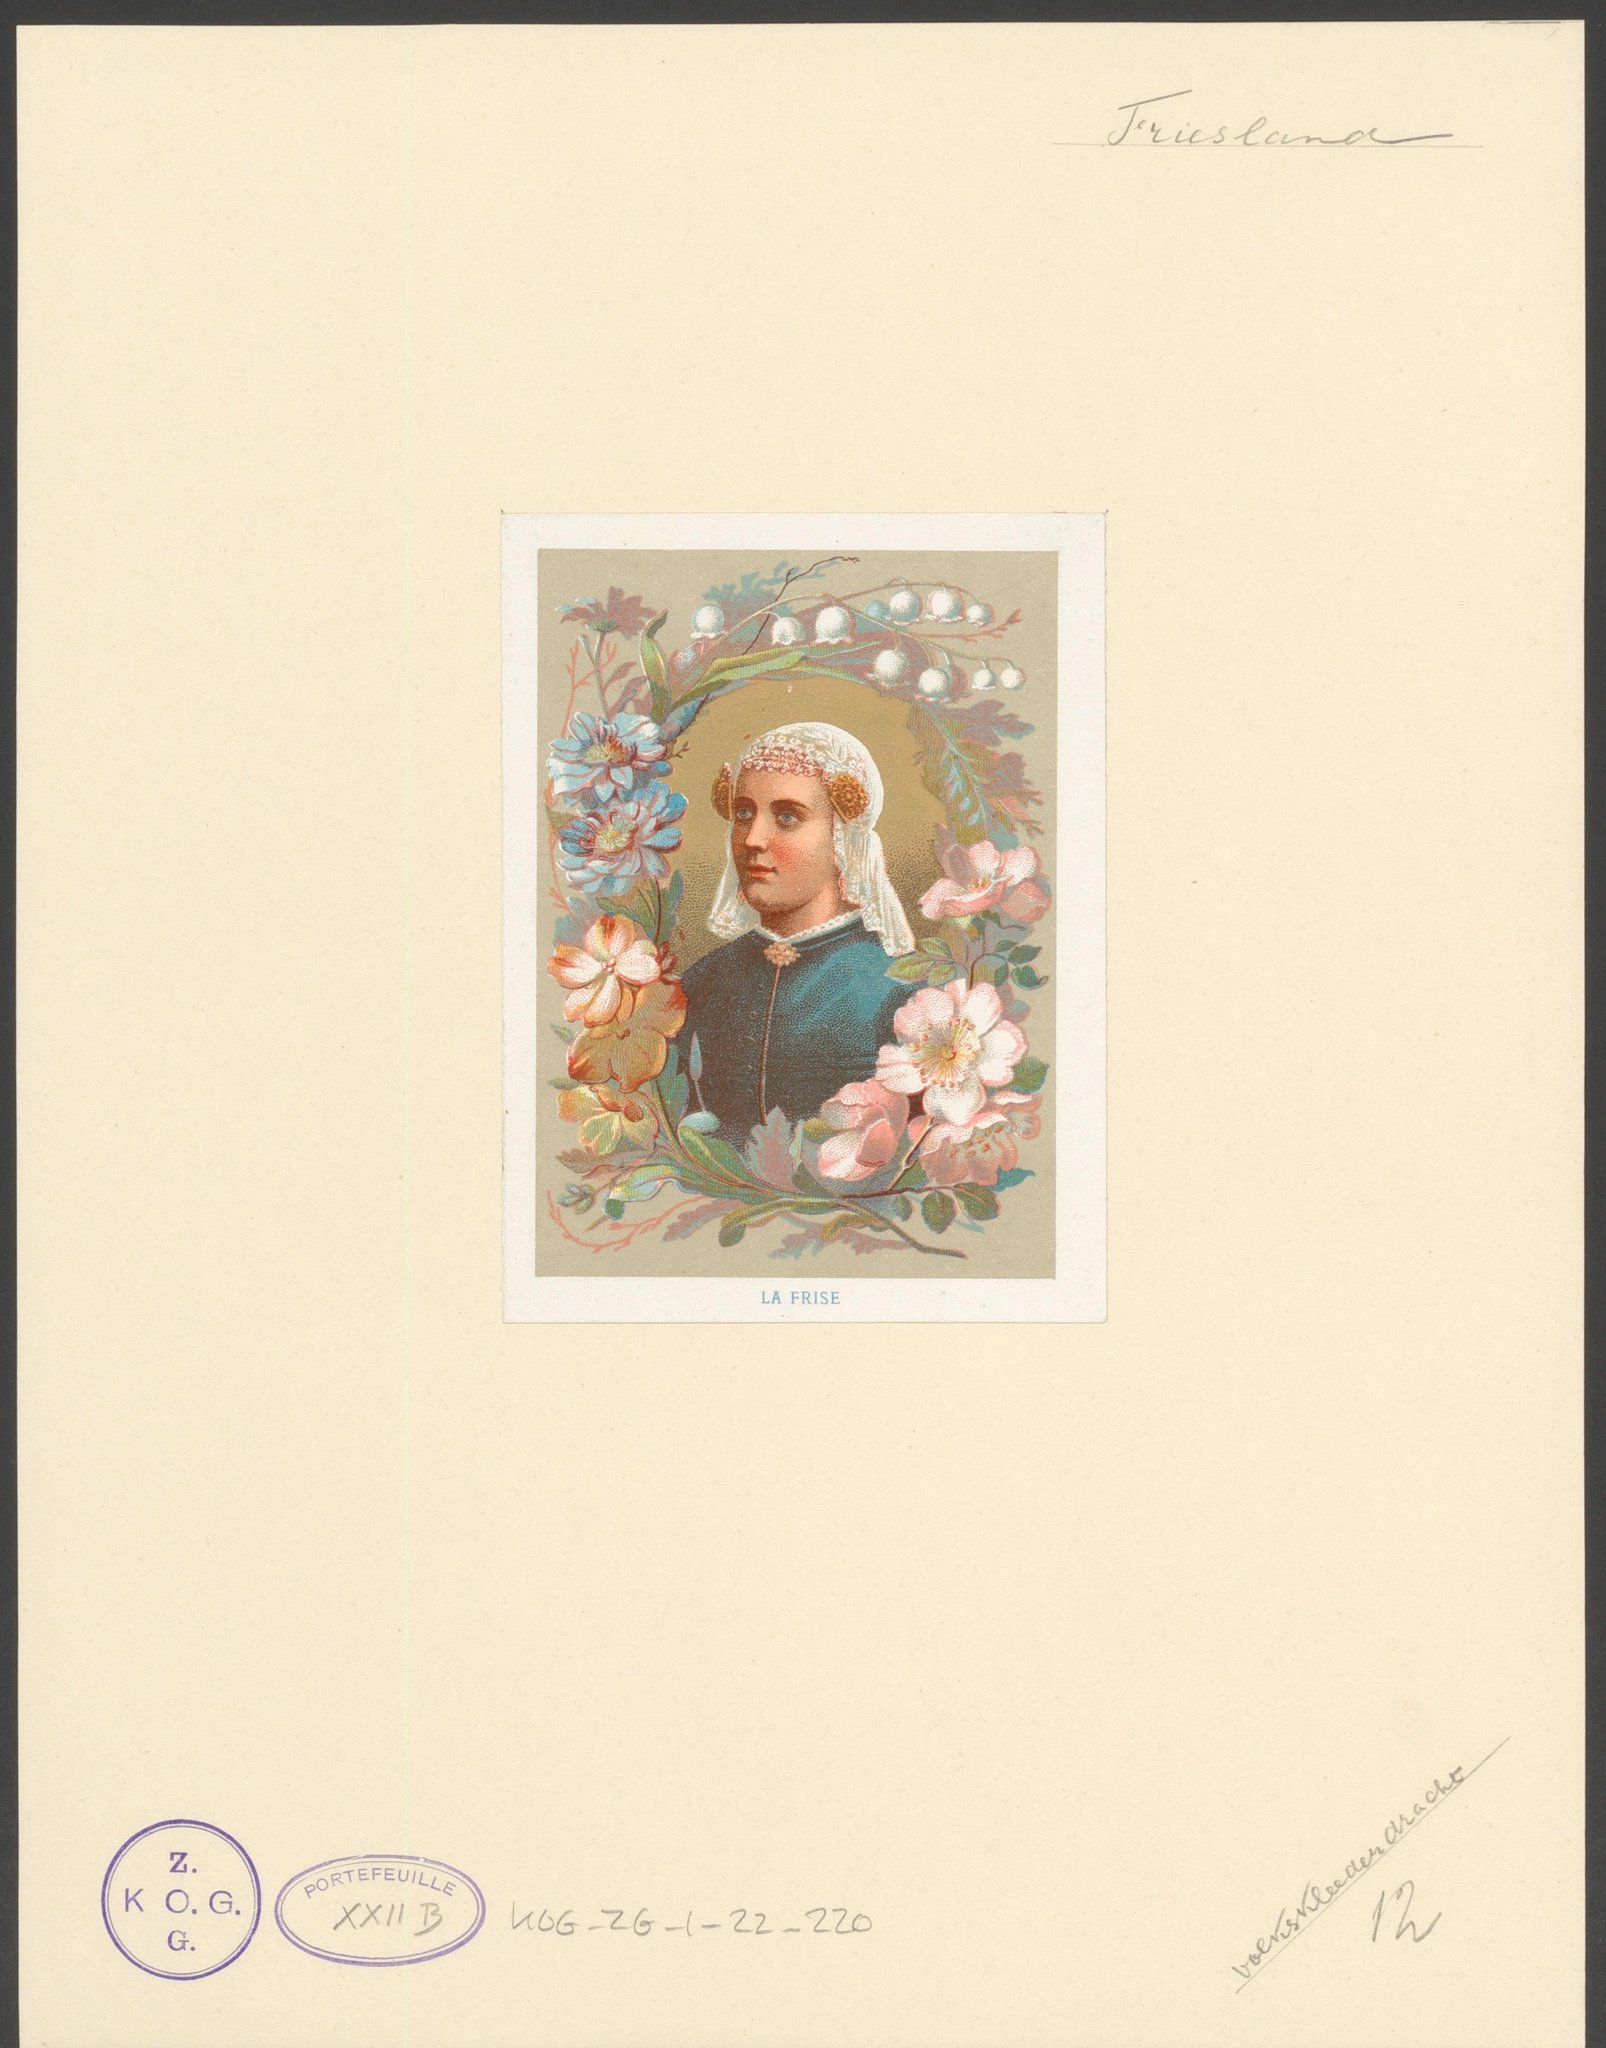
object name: print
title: Friese vrouw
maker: Anonymous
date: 1890-1940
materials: paper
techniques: chromolithography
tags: clothes, costume (+ women's clothes), folk costume, regional costume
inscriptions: collector's mark, collector's mark: Lugt 1641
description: Buste van een Friese vrouw, met kap, binnen een krans van bloemen. Onderwerpsrubrieken binnen de Atlas Zeden en Gewoonten: De Kleeding, Volkskleederdracht, Zeeland.